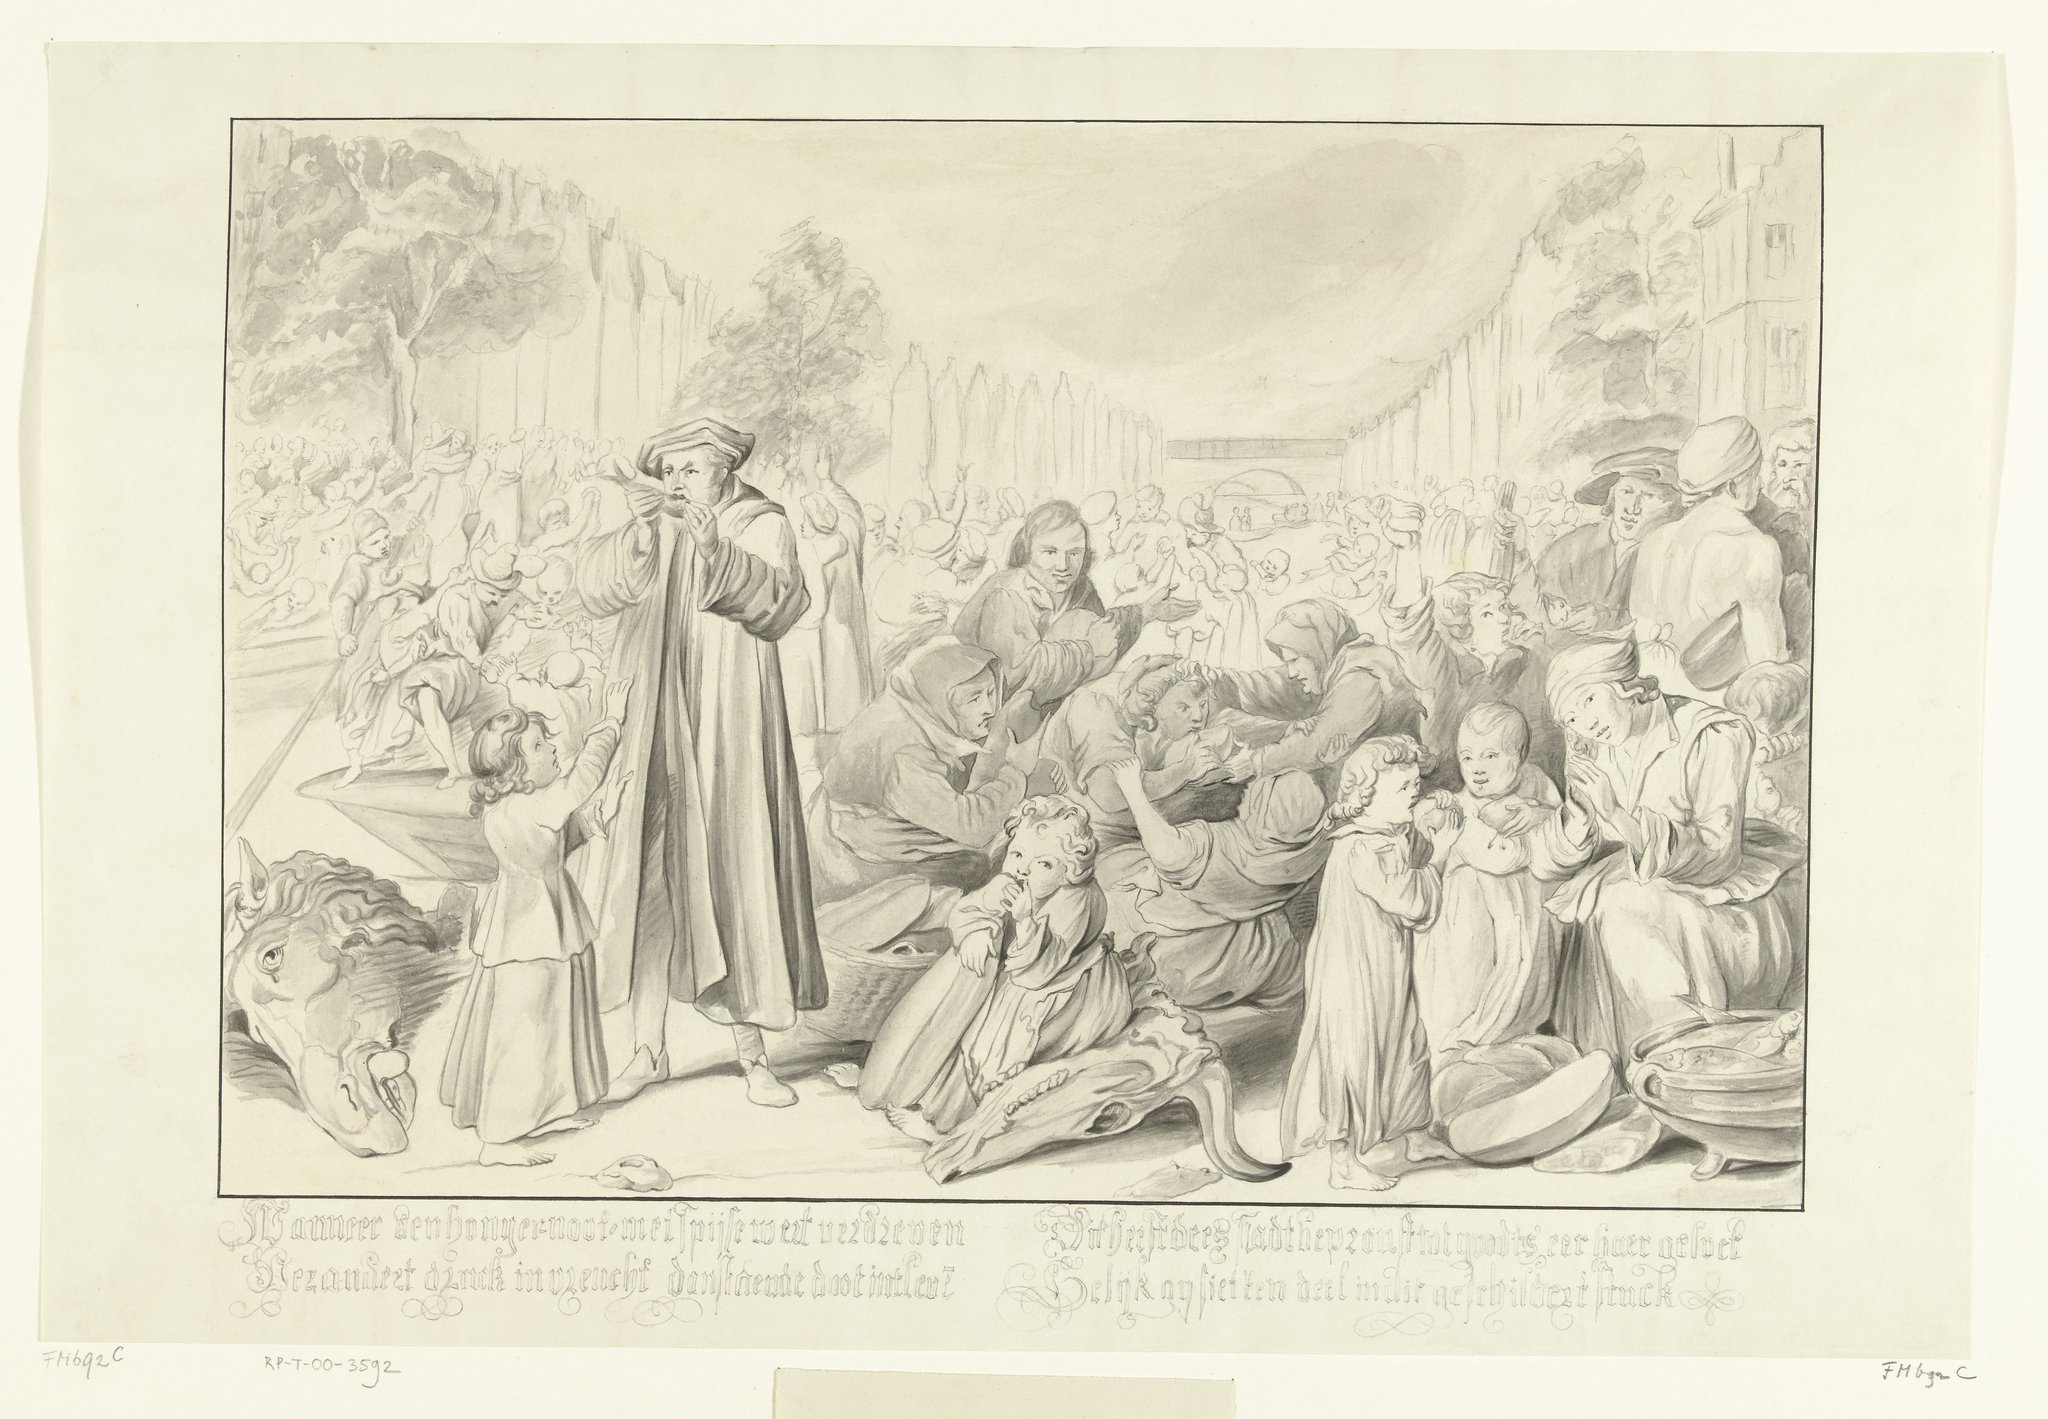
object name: historieplaat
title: De spijziging der verloste Leidenaren, 1574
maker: j.c. wendel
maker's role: draughtsman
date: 1867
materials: ink, paper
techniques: brush, pen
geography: netherlands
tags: raising the siege with outside assistance, relief, leiden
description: Het uitreiken van brood en haring aan de uitgehongerde Leidenaren bij het ontzet van Leiden, 3 oktober 1574. Vrouwen en kinderen eten en vechten om het brood, rechts vouwt een vrouw haar handen in dankbaarheid. Links op de grond een paardenhoofd. Onder de voorstelling een vers van 4 regels in het Nederlands. Met hierbij een handgeschreven briefje met een beschrijving van het schilderij.